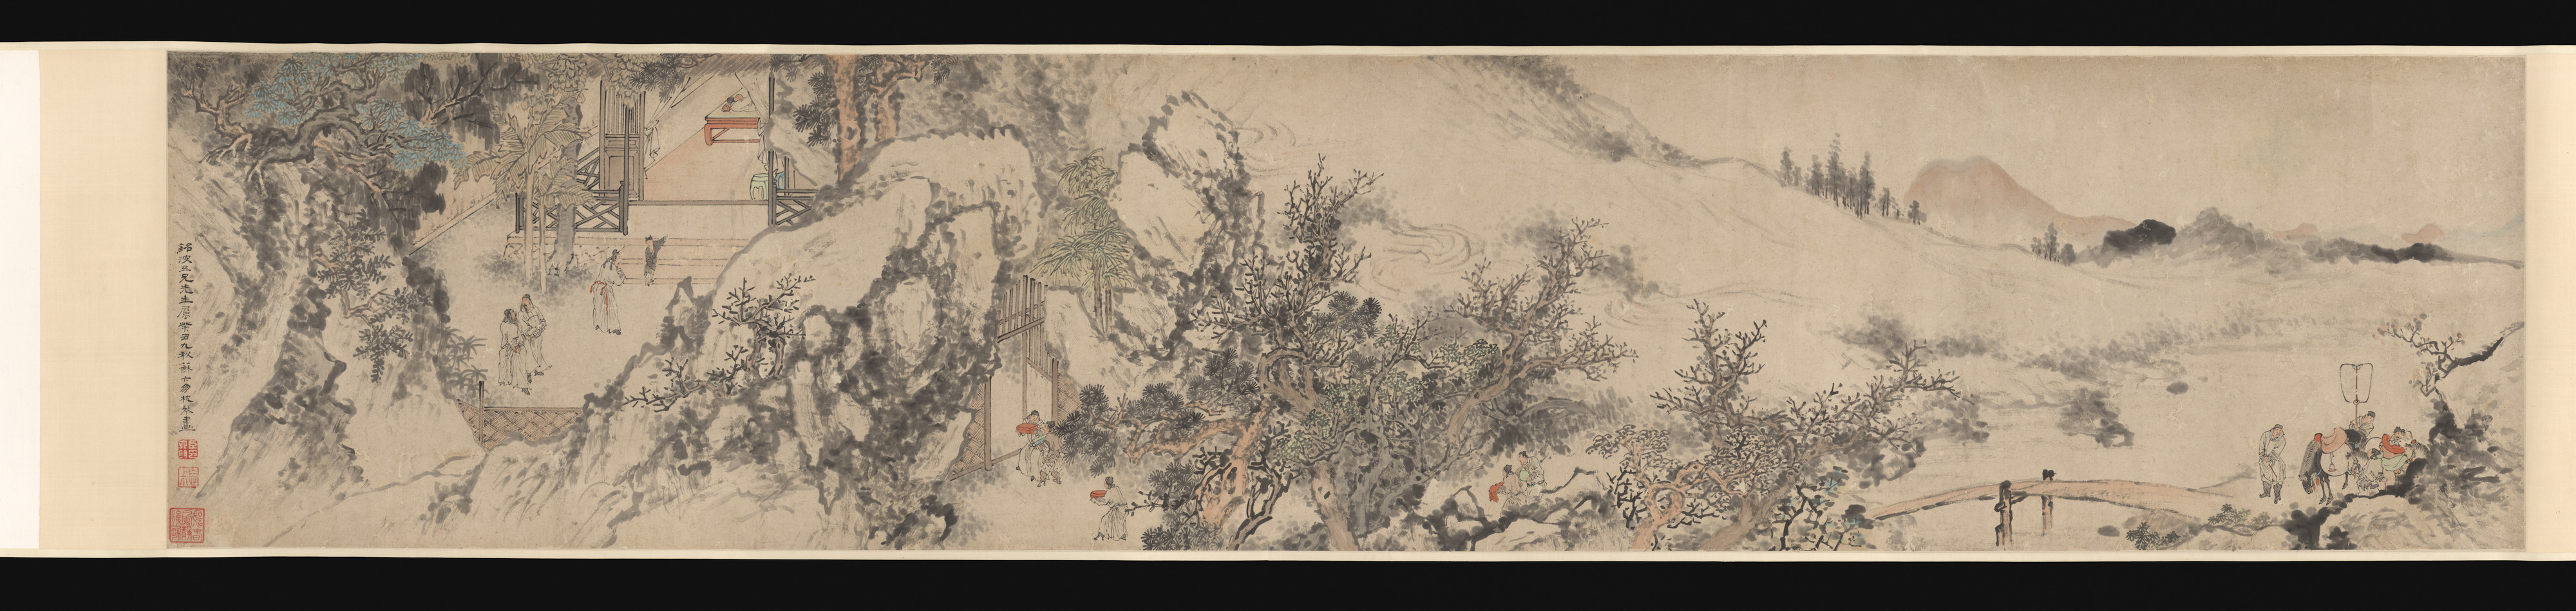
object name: handscroll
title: Three Visits to the Thatched Hut of Zhuge Liange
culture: chinese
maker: su liupeng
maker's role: artist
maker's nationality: chinese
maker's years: 1791-1862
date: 1853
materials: ink, paper